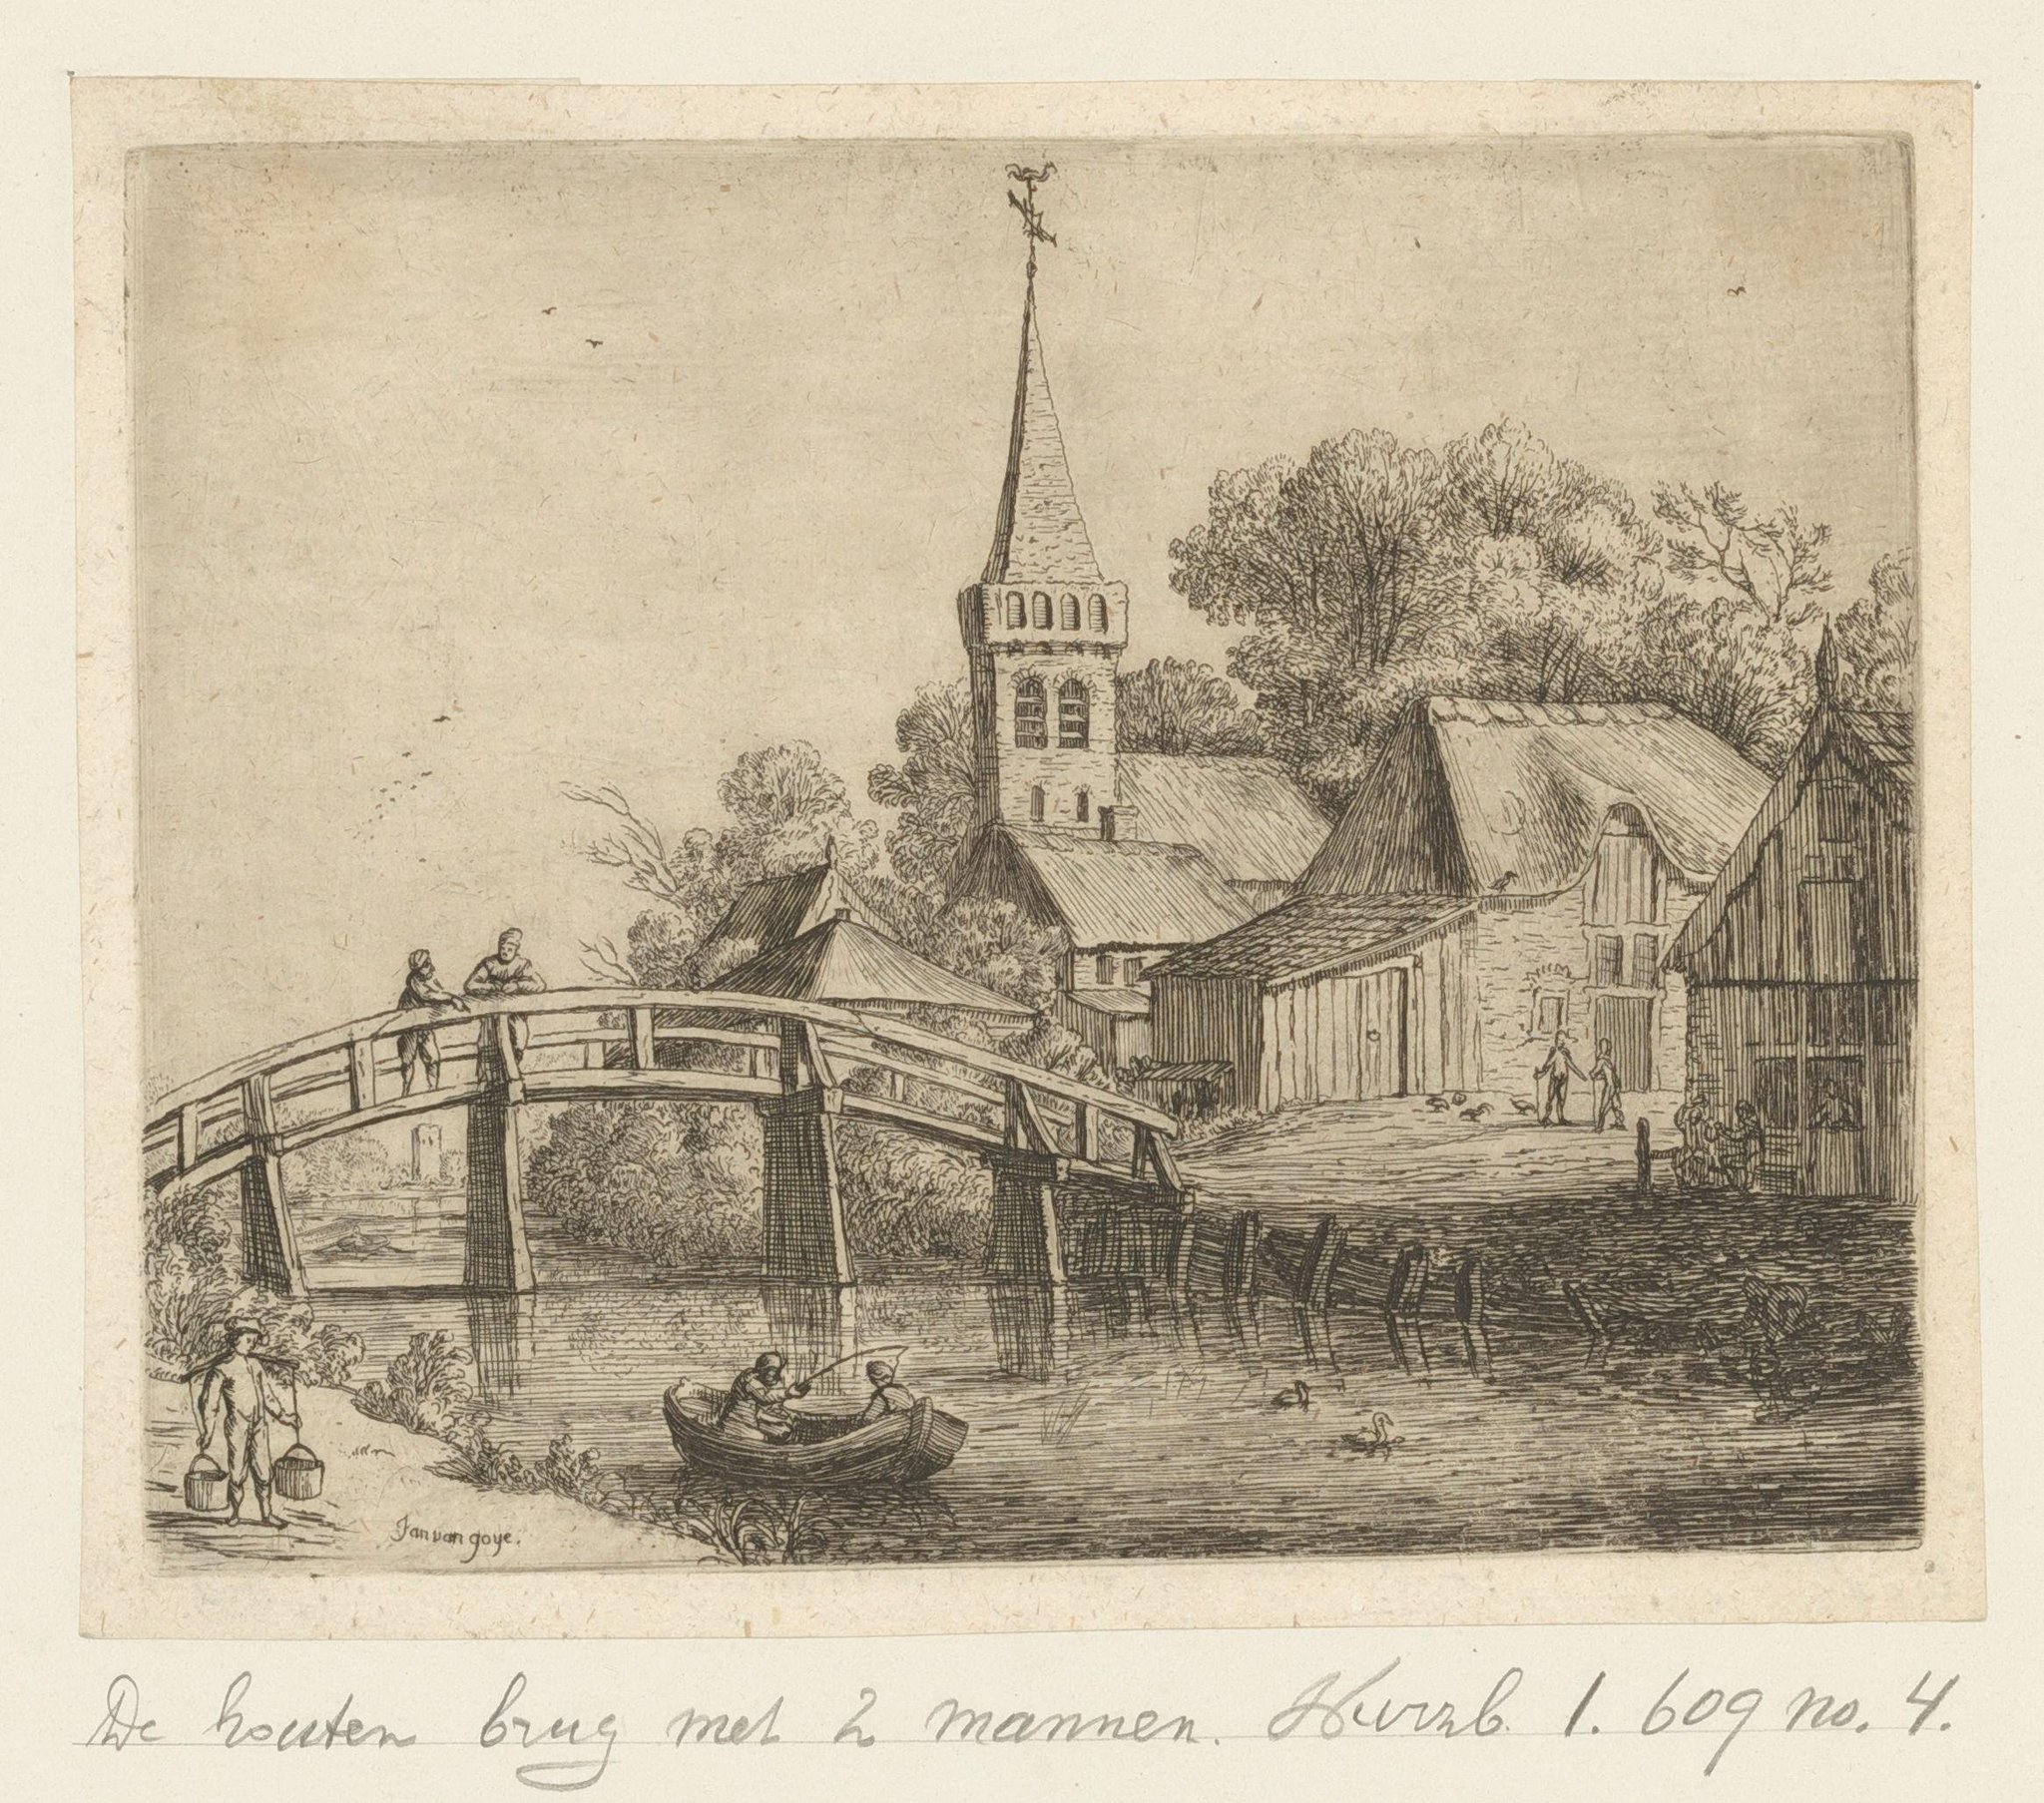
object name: print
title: Landschappen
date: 1726-1799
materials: paper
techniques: etching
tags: parts of church exterior and annexes: tower - qq - small church, chapel, landscape with bridge, viaduct or aqueduct, rowing-boat, canoe, etc.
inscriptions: stamp, collector's mark: Lugt 1641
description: Een houten brug over een vaart bij een dorp. Op de brug staan twee mensen. In het water ligt een bootje met twee vissers. Langs de oever loopt een man die twee emmers draagt. Onderwerpsrubrieken binnen de Atlas Zeden en Gewoonten: Handel, nijverheid en verkeer, Buitenleven.